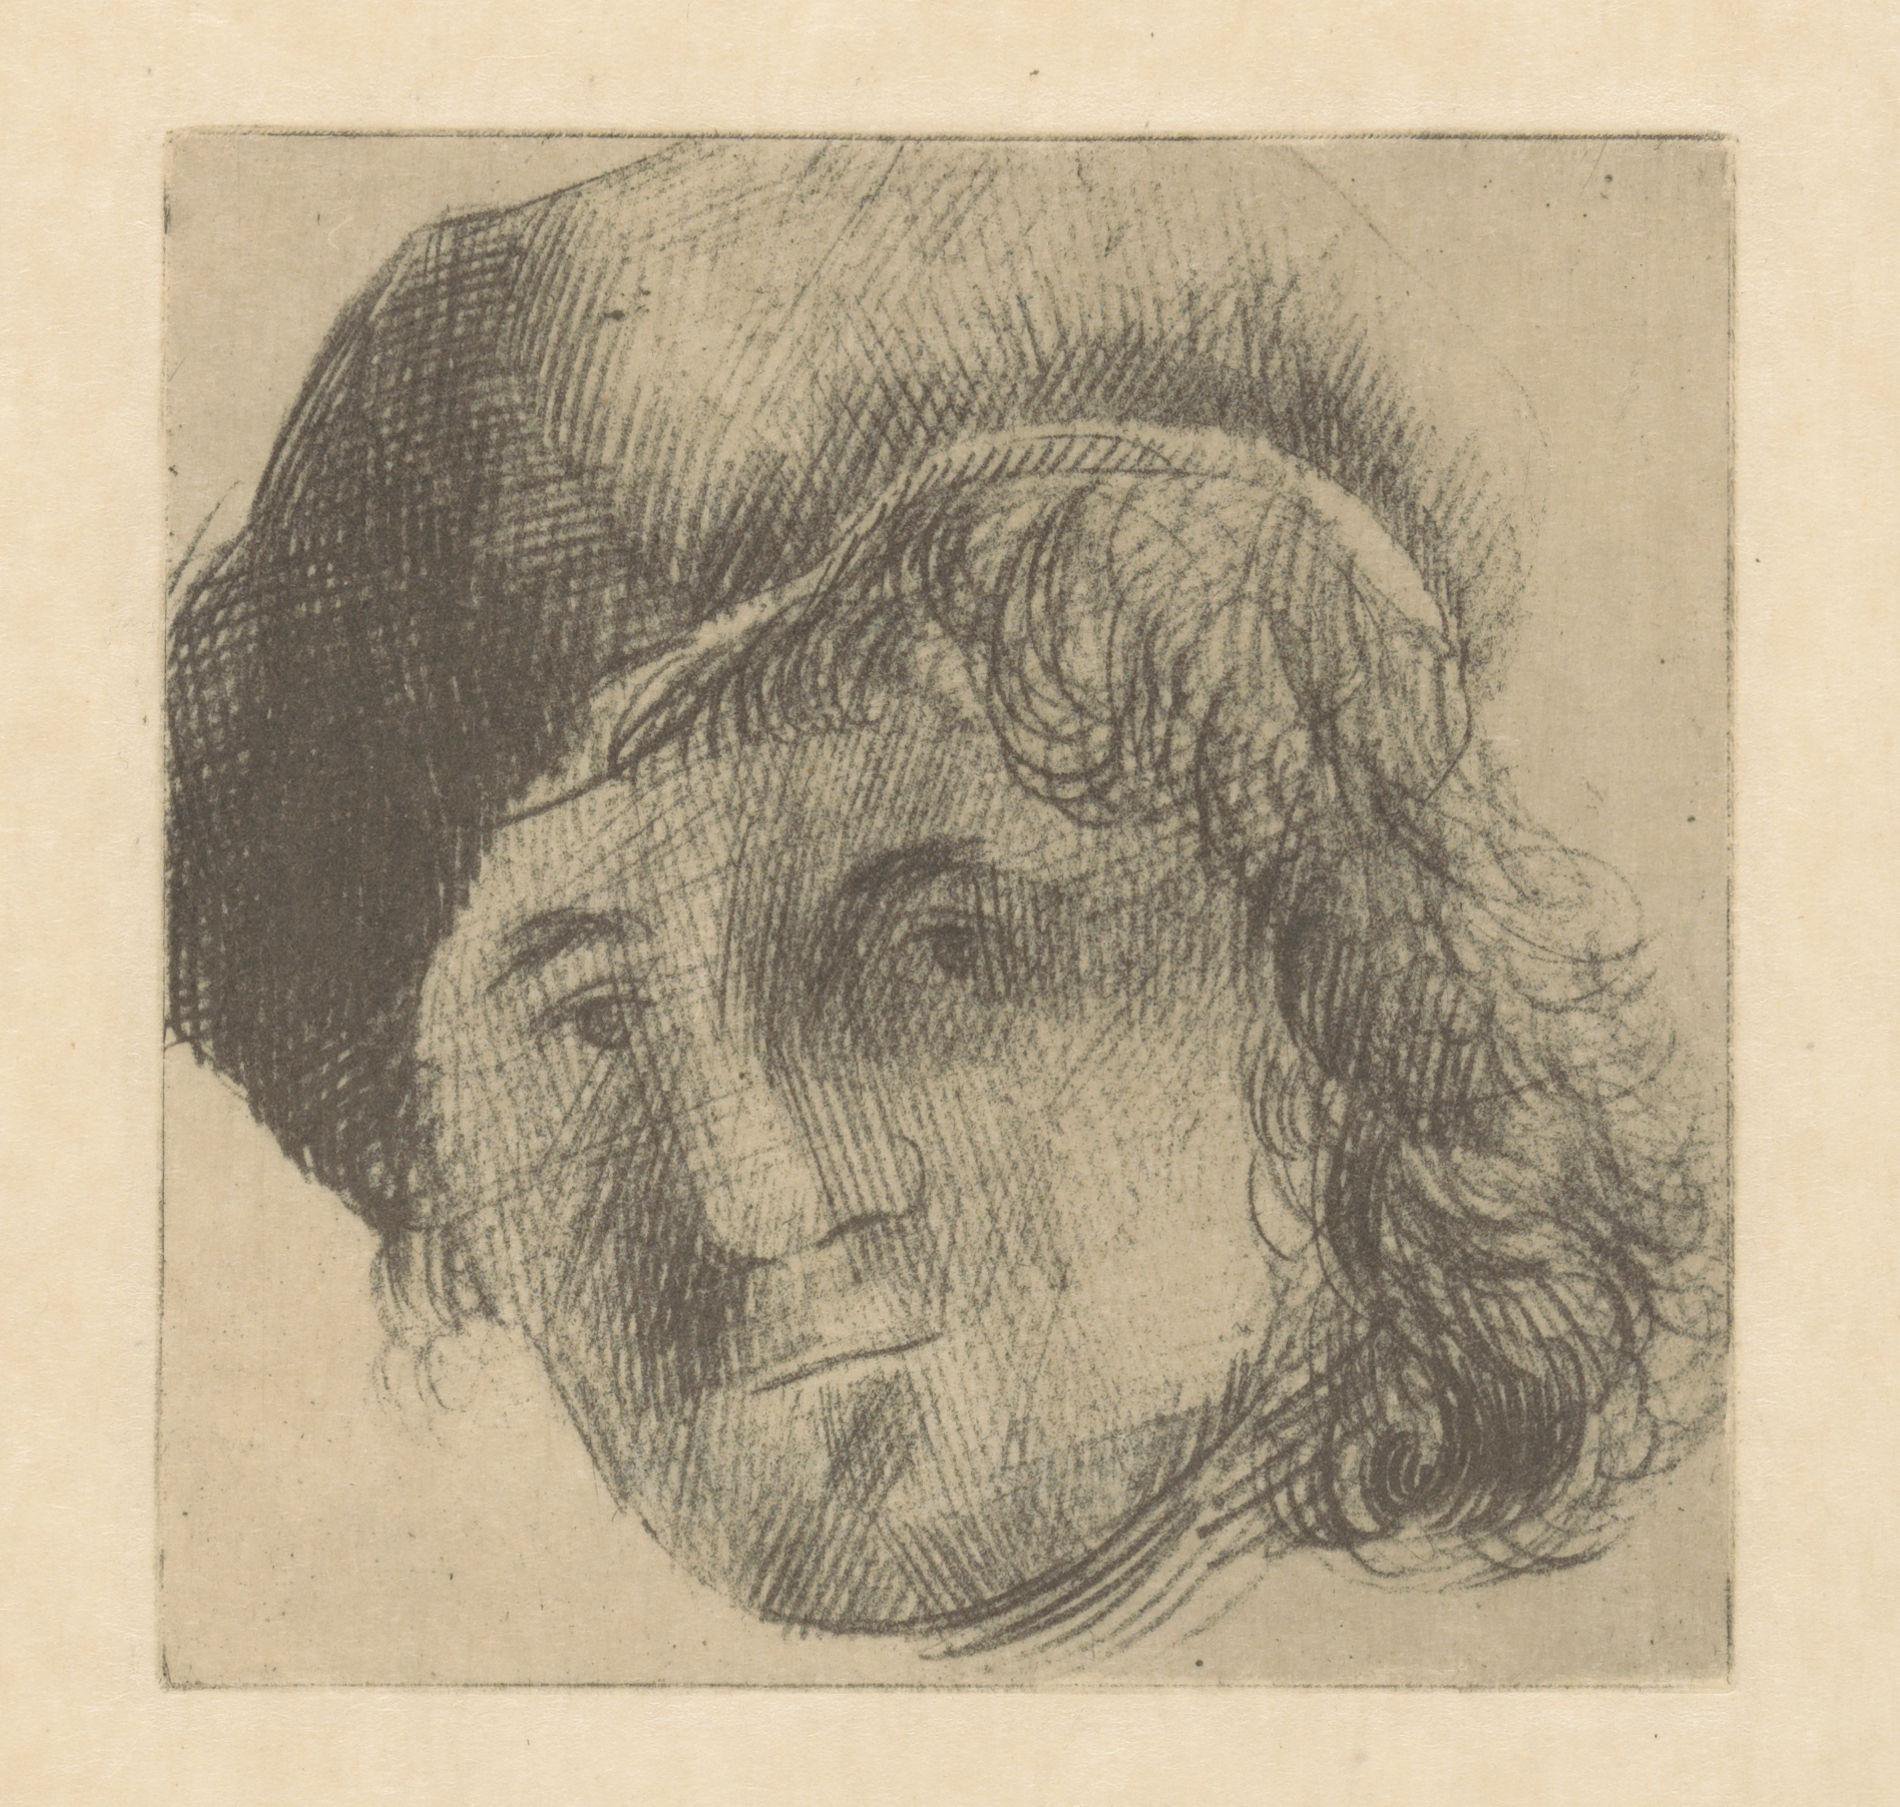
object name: print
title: Jonge man met muts en krullend haar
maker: marius holleman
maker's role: draughtsman, print maker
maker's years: 1878-1926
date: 1904-1926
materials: paper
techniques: etching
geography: groningen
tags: youth, adolescent, head-gear: hat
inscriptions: collector's mark: Lugt 2228